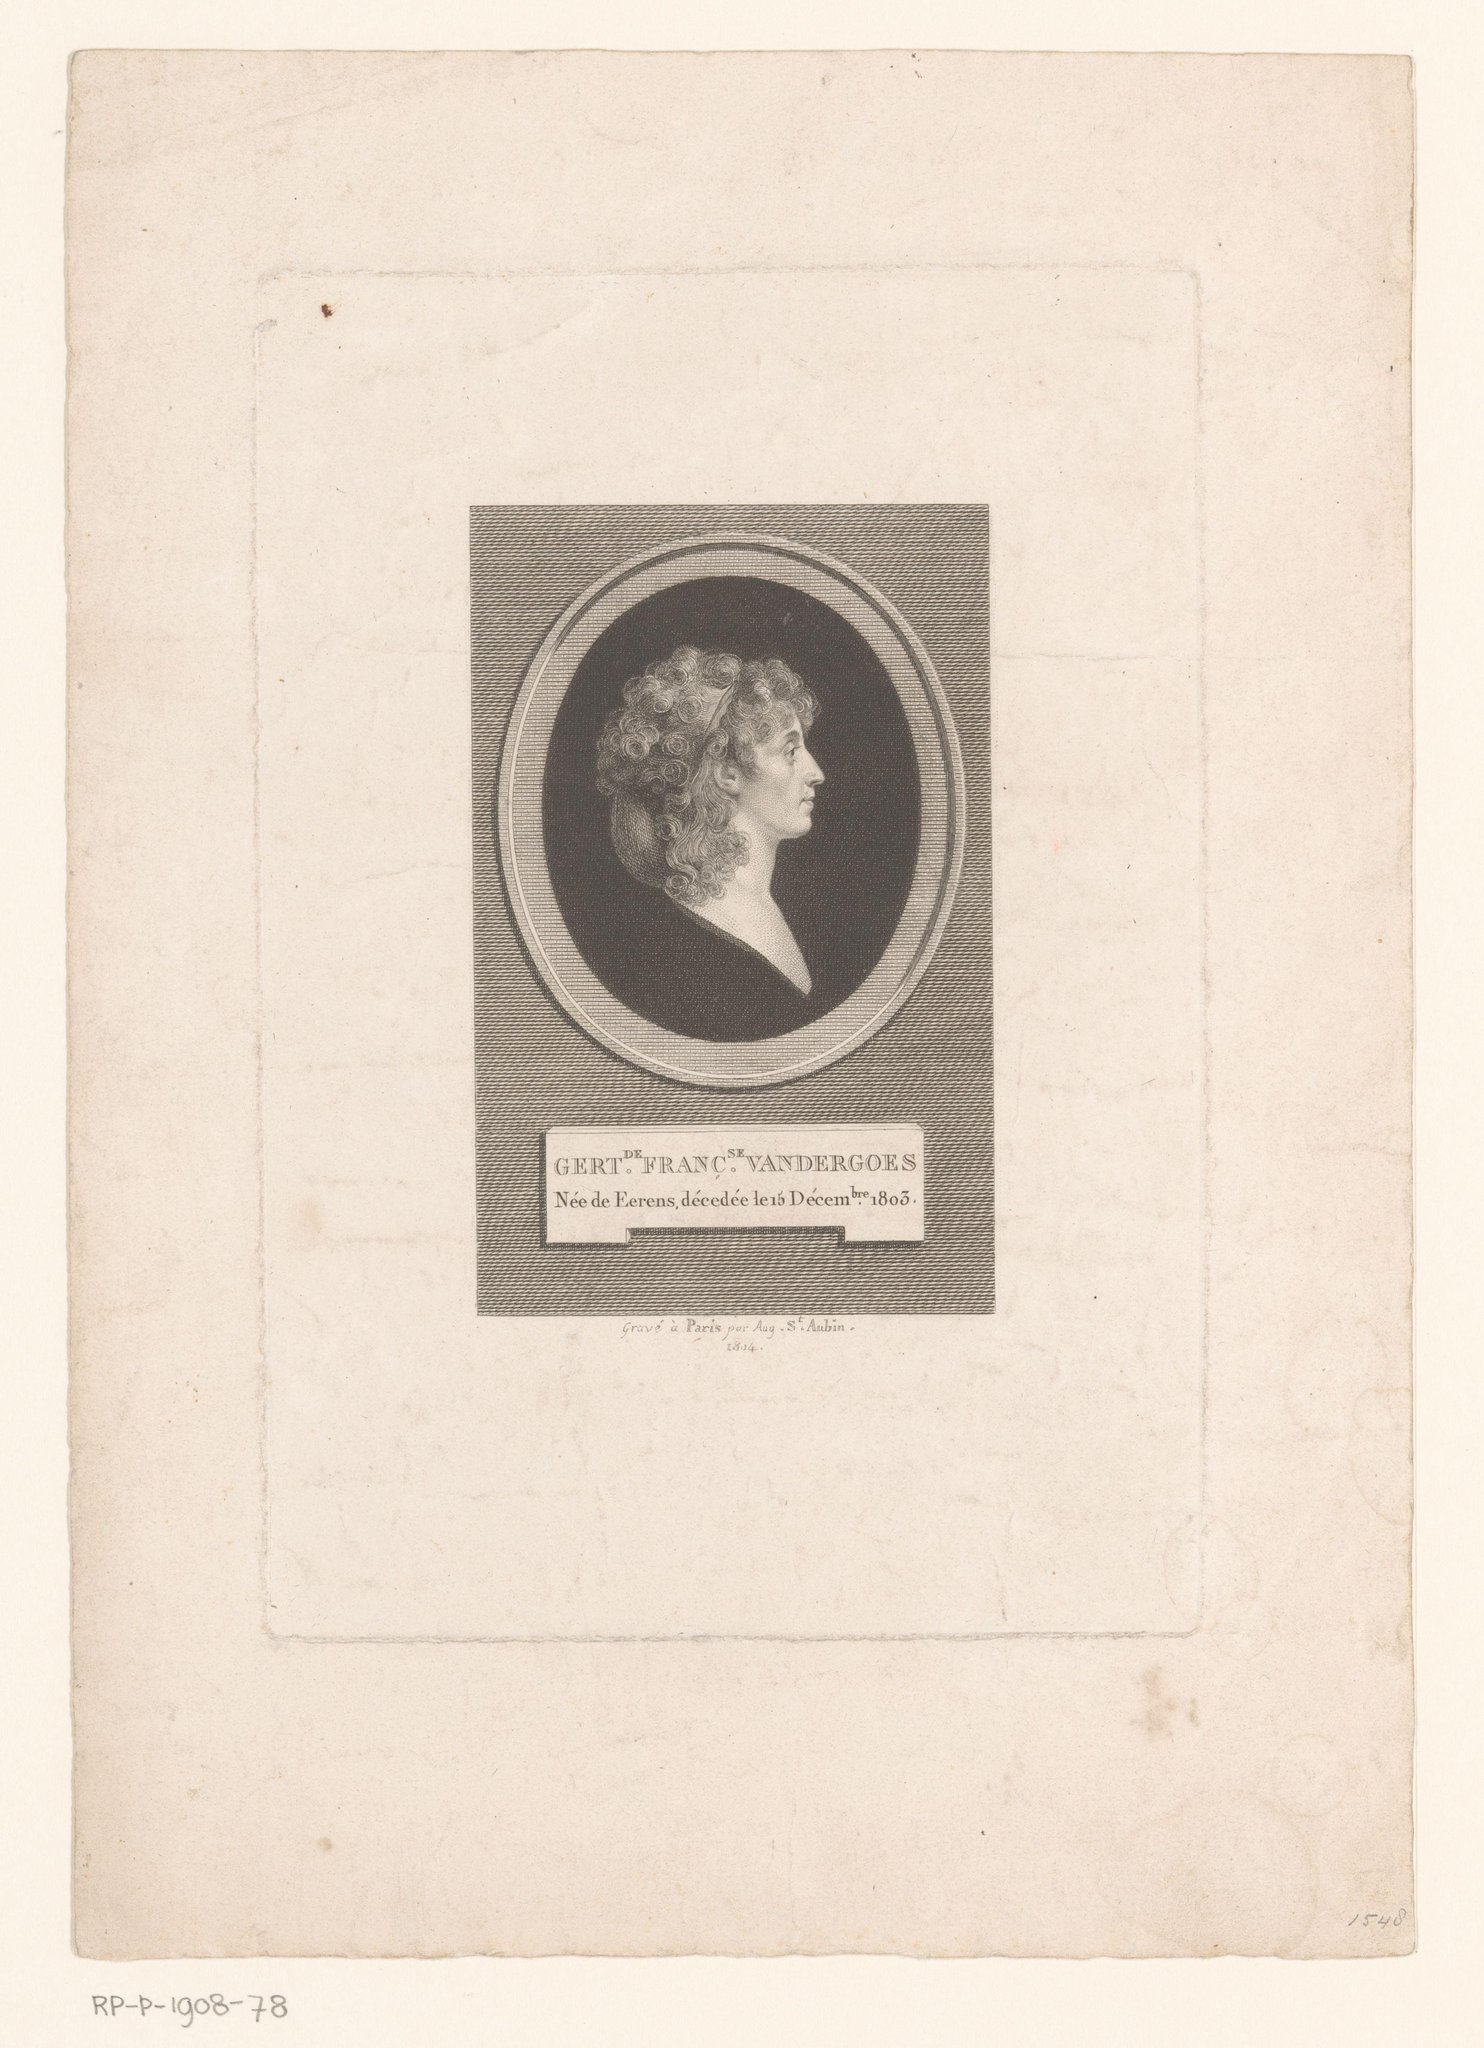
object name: print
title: Portret van Gertrude Françoise Vandergoes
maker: augustin de saint-aubin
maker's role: draughtsman, print maker, publisher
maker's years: 1736-1807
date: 1804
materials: paper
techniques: engraving, etching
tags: historical persons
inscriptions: collector's mark: Lugt 2228